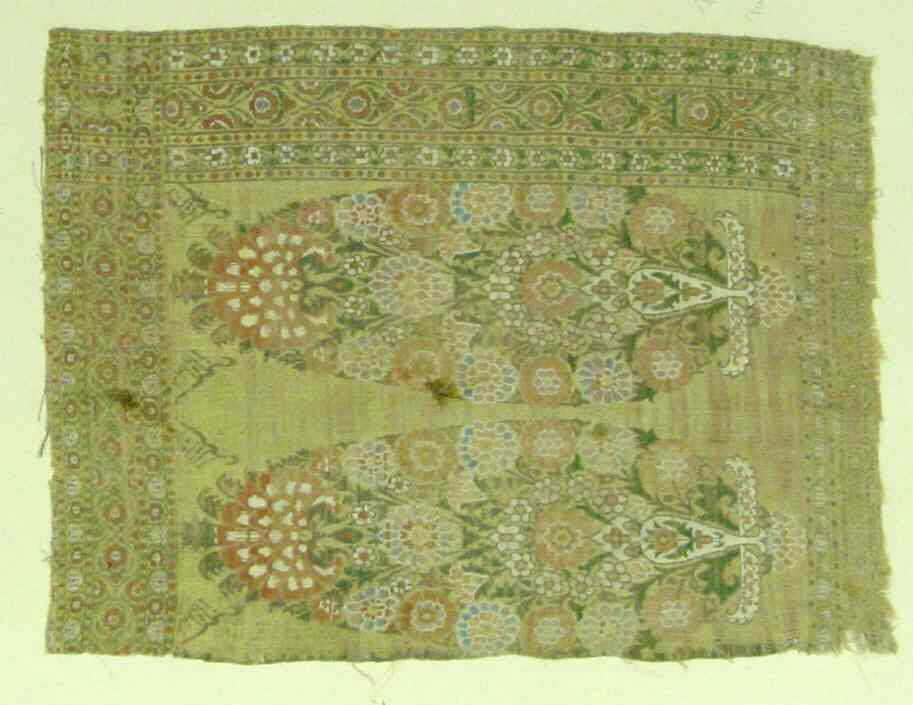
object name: textile fragment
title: Fragment of Sash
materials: silk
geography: iran